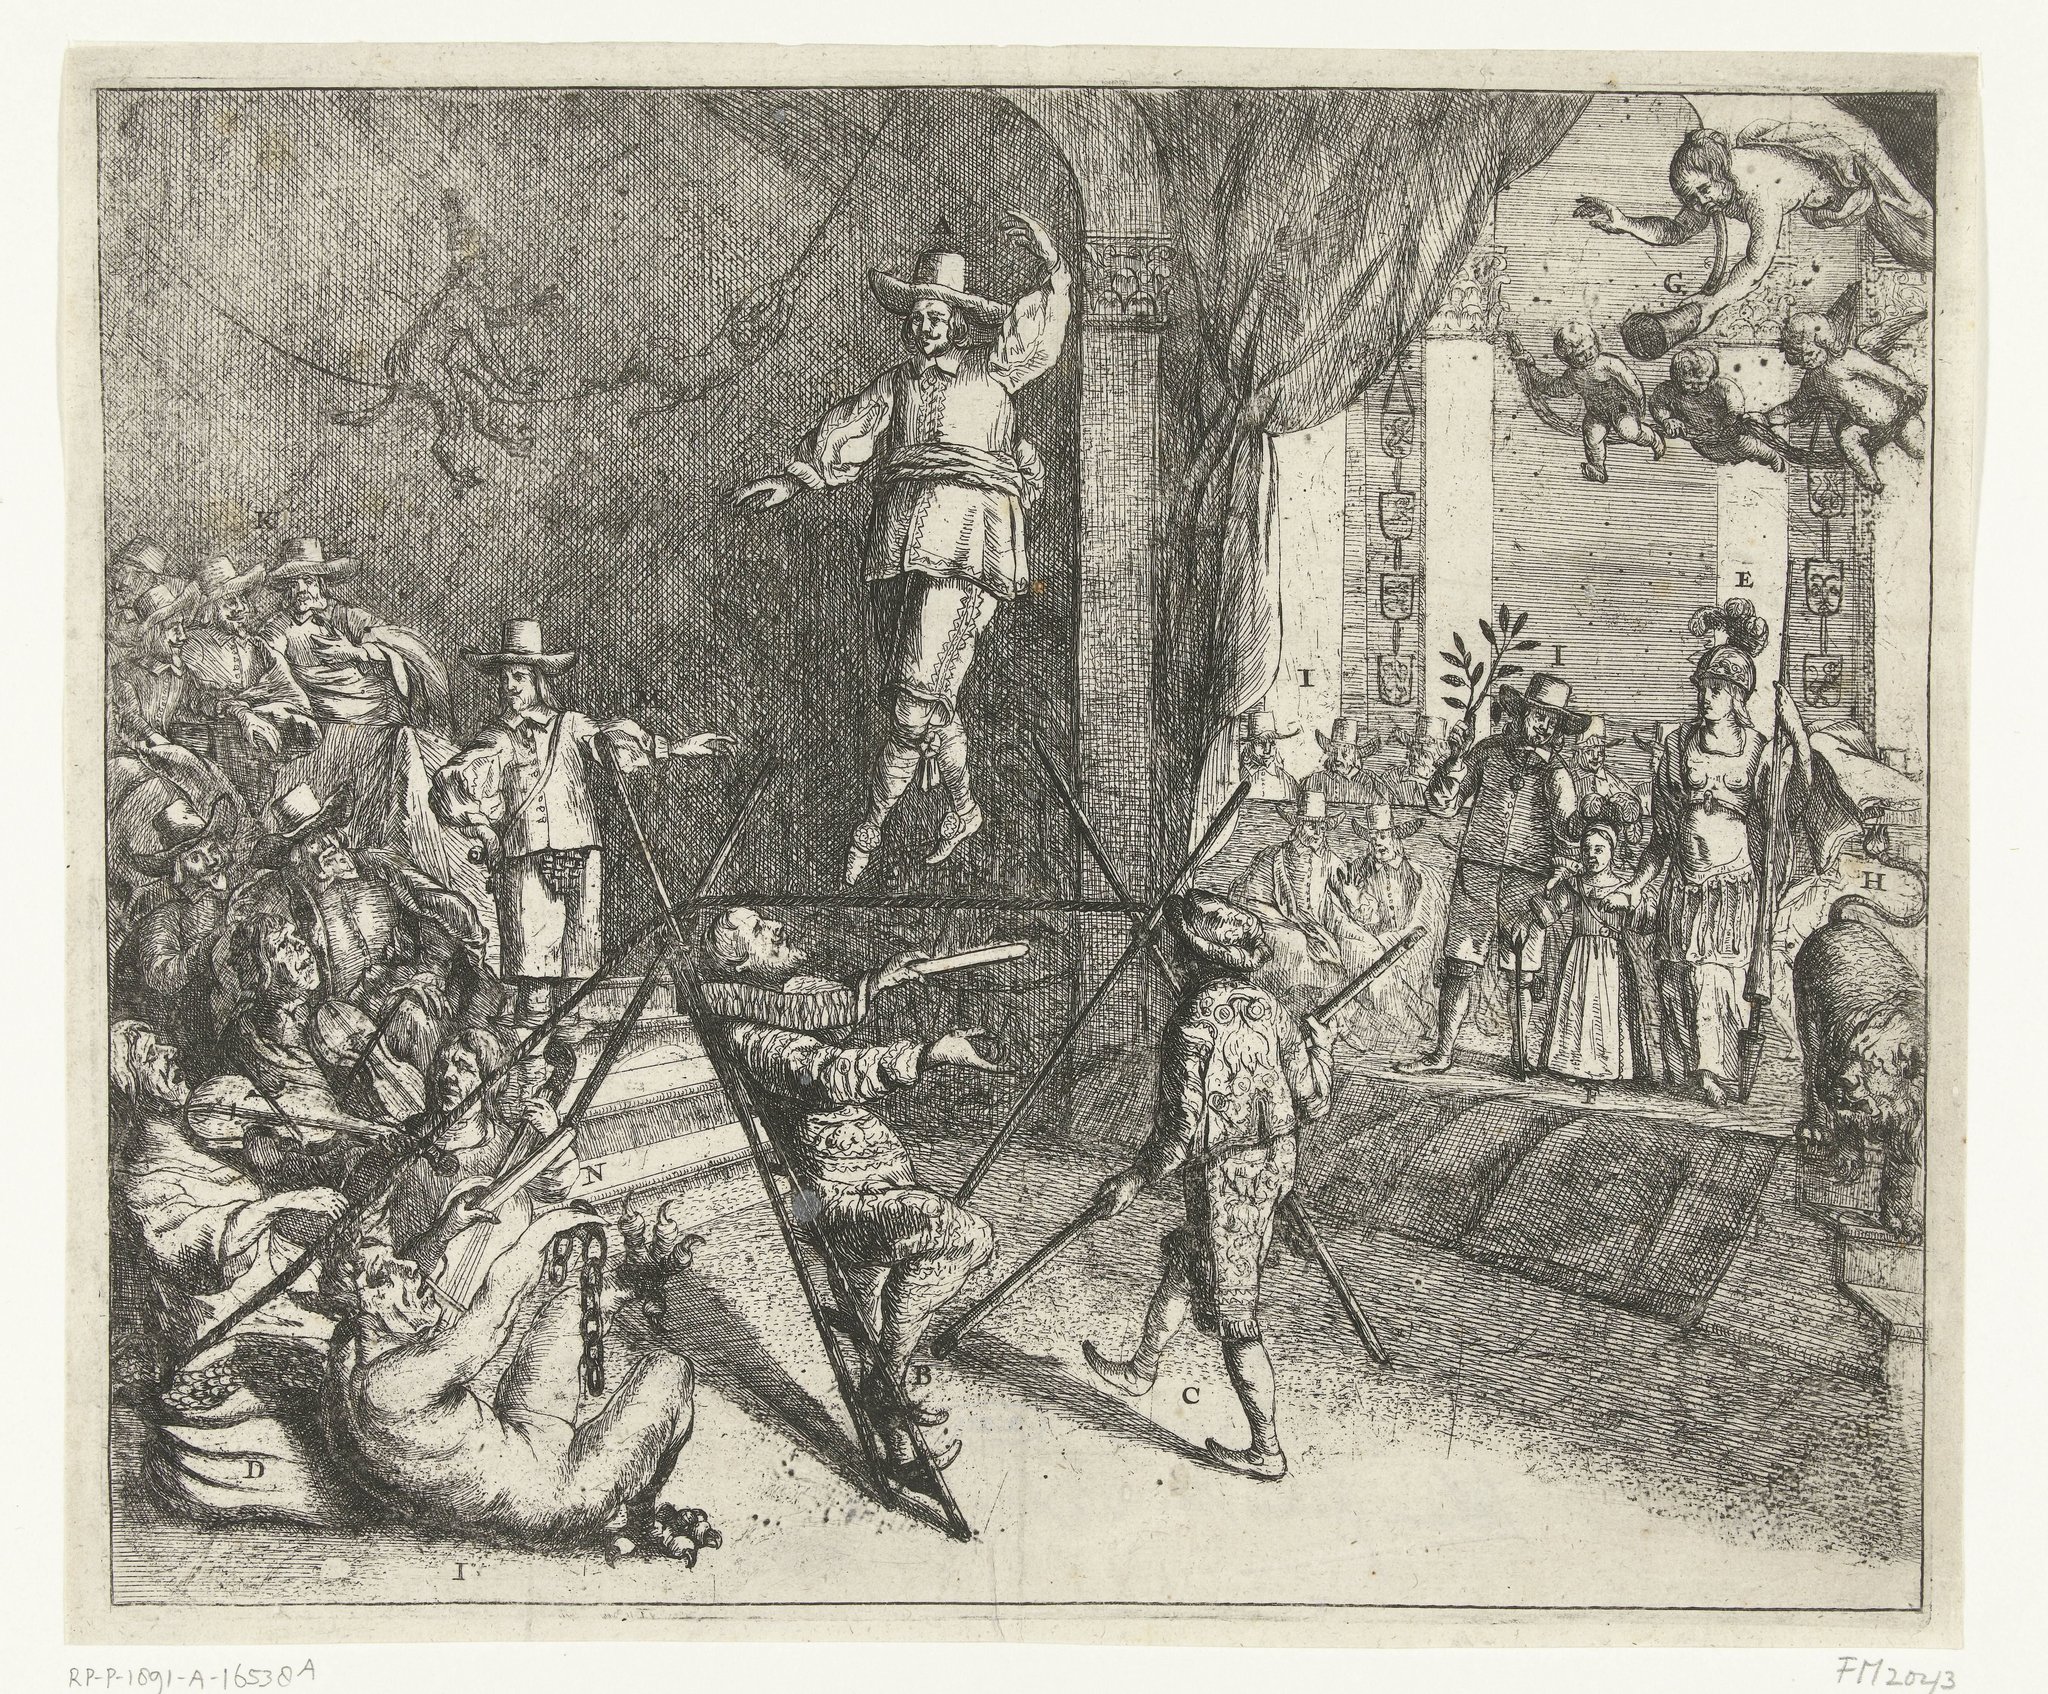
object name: print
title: Den Engelschen Koort-Dansser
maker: dirk stoop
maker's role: draughtsman, painter, print maker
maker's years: 1615-1686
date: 1652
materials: paper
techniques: etching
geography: northern netherlands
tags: the hague, william iii (prince of orange and king of england, scotland, and ireland), london, oliver cromwell, tight-ropewalker, political caricatures and satires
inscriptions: collector's mark: ‘Seymour Haden’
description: Spotprent op Oliver Cromwell en Engeland ten tijde van de Eerste Engelse Oorlog. Cromwell als een koorddanser op een koord opgehouden door Fairfax en een hoveling. Links kijken de Engelsen toe. Hieronder bevinden zich een duivel, enkele muzikanten en Meester Pieter Cornel (waarschijnlijk de predikant Hugh Peters). Op de achtergrond slingeren twee apen. Rechts de jonge prins Willem III staande tussen een Hollander met vredestak en Pallas, rechts de Nederlandse Leeuw, op de achtergrond de leden van de Staten. In de de lucht de Faam. Bij de prent behoort een tekstblad.